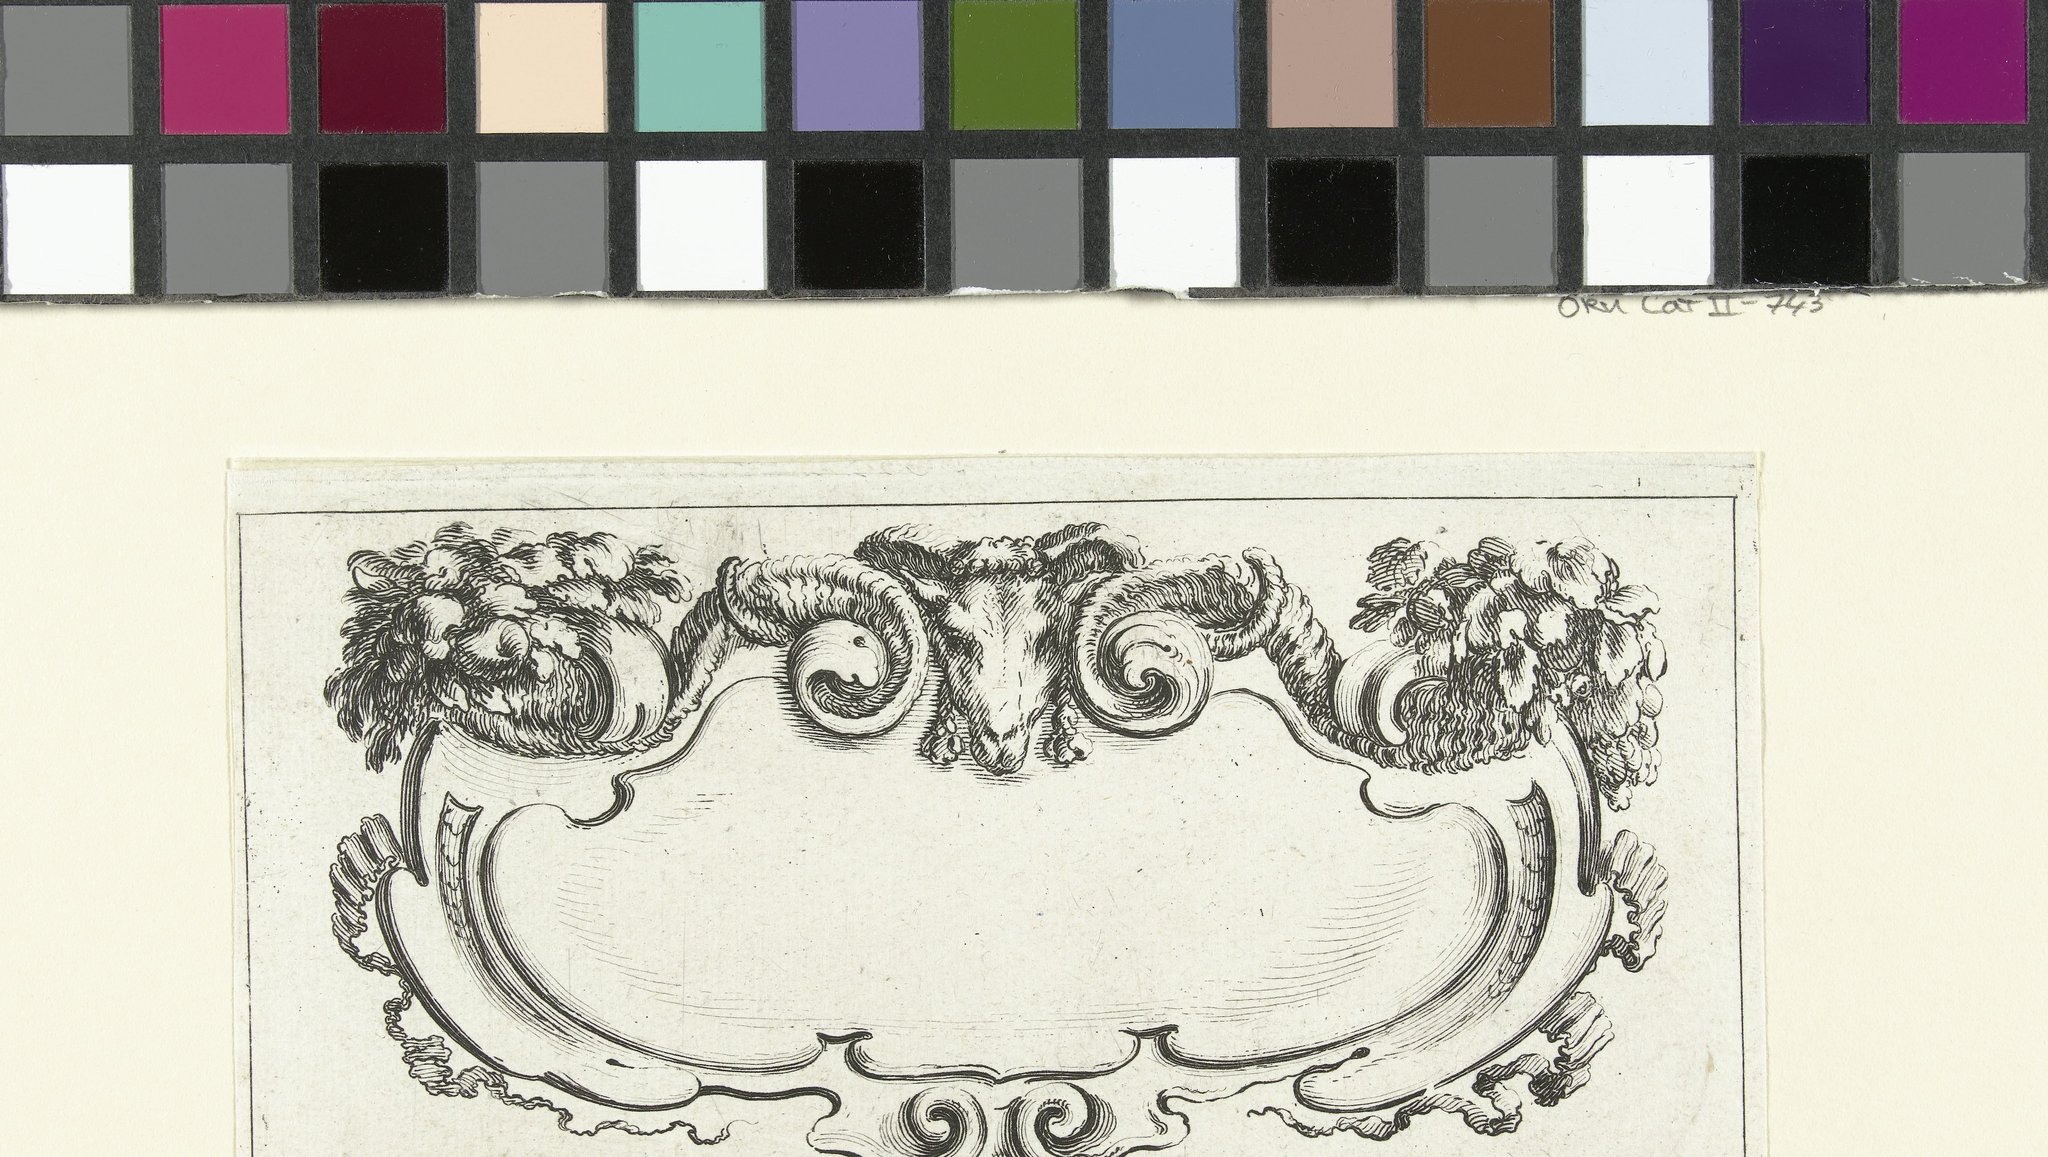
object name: print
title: Cartouche met ramskop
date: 1645-1647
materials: paper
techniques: etching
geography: france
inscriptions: collector's mark: Lugt 240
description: De hoorns van de ram zijn verweven met twee hoornen des overvloeds. Uit tweede editie.